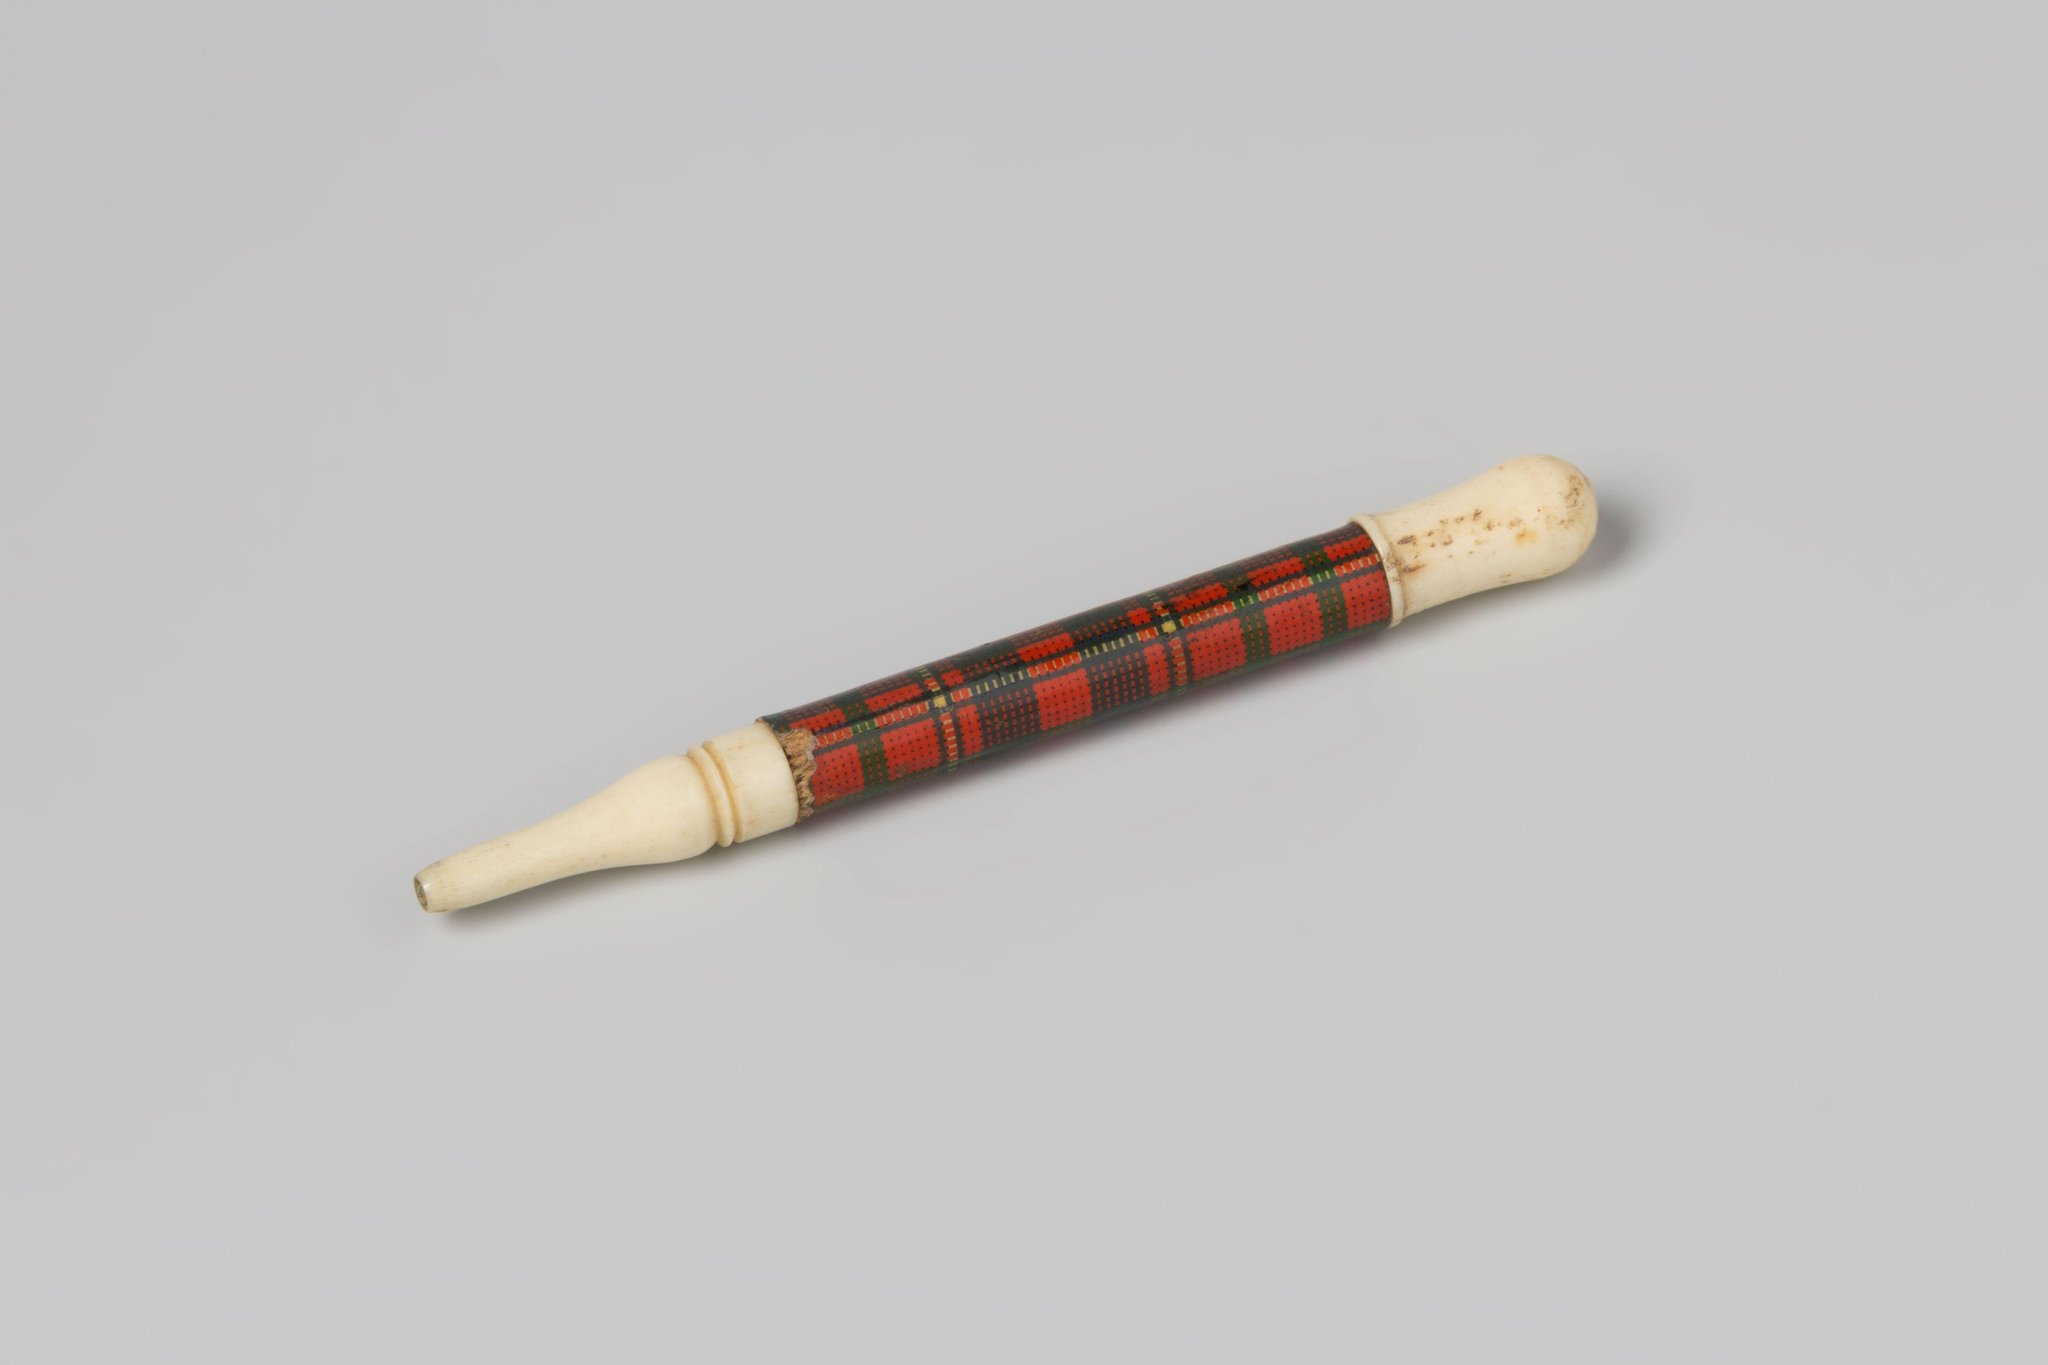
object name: writing instrument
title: Vulpotlood van been, waarvan het middelste deel het motief van een Schotse ruit heeft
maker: Anonymous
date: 1925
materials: bone, lacquer, paper, wood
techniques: cutting, lacquer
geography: scotland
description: Vulpotlood van been, waarvan het middelste deel het motief van een Schotse ruit heeft. Aan de puntige zijde een smalle ronde opening.